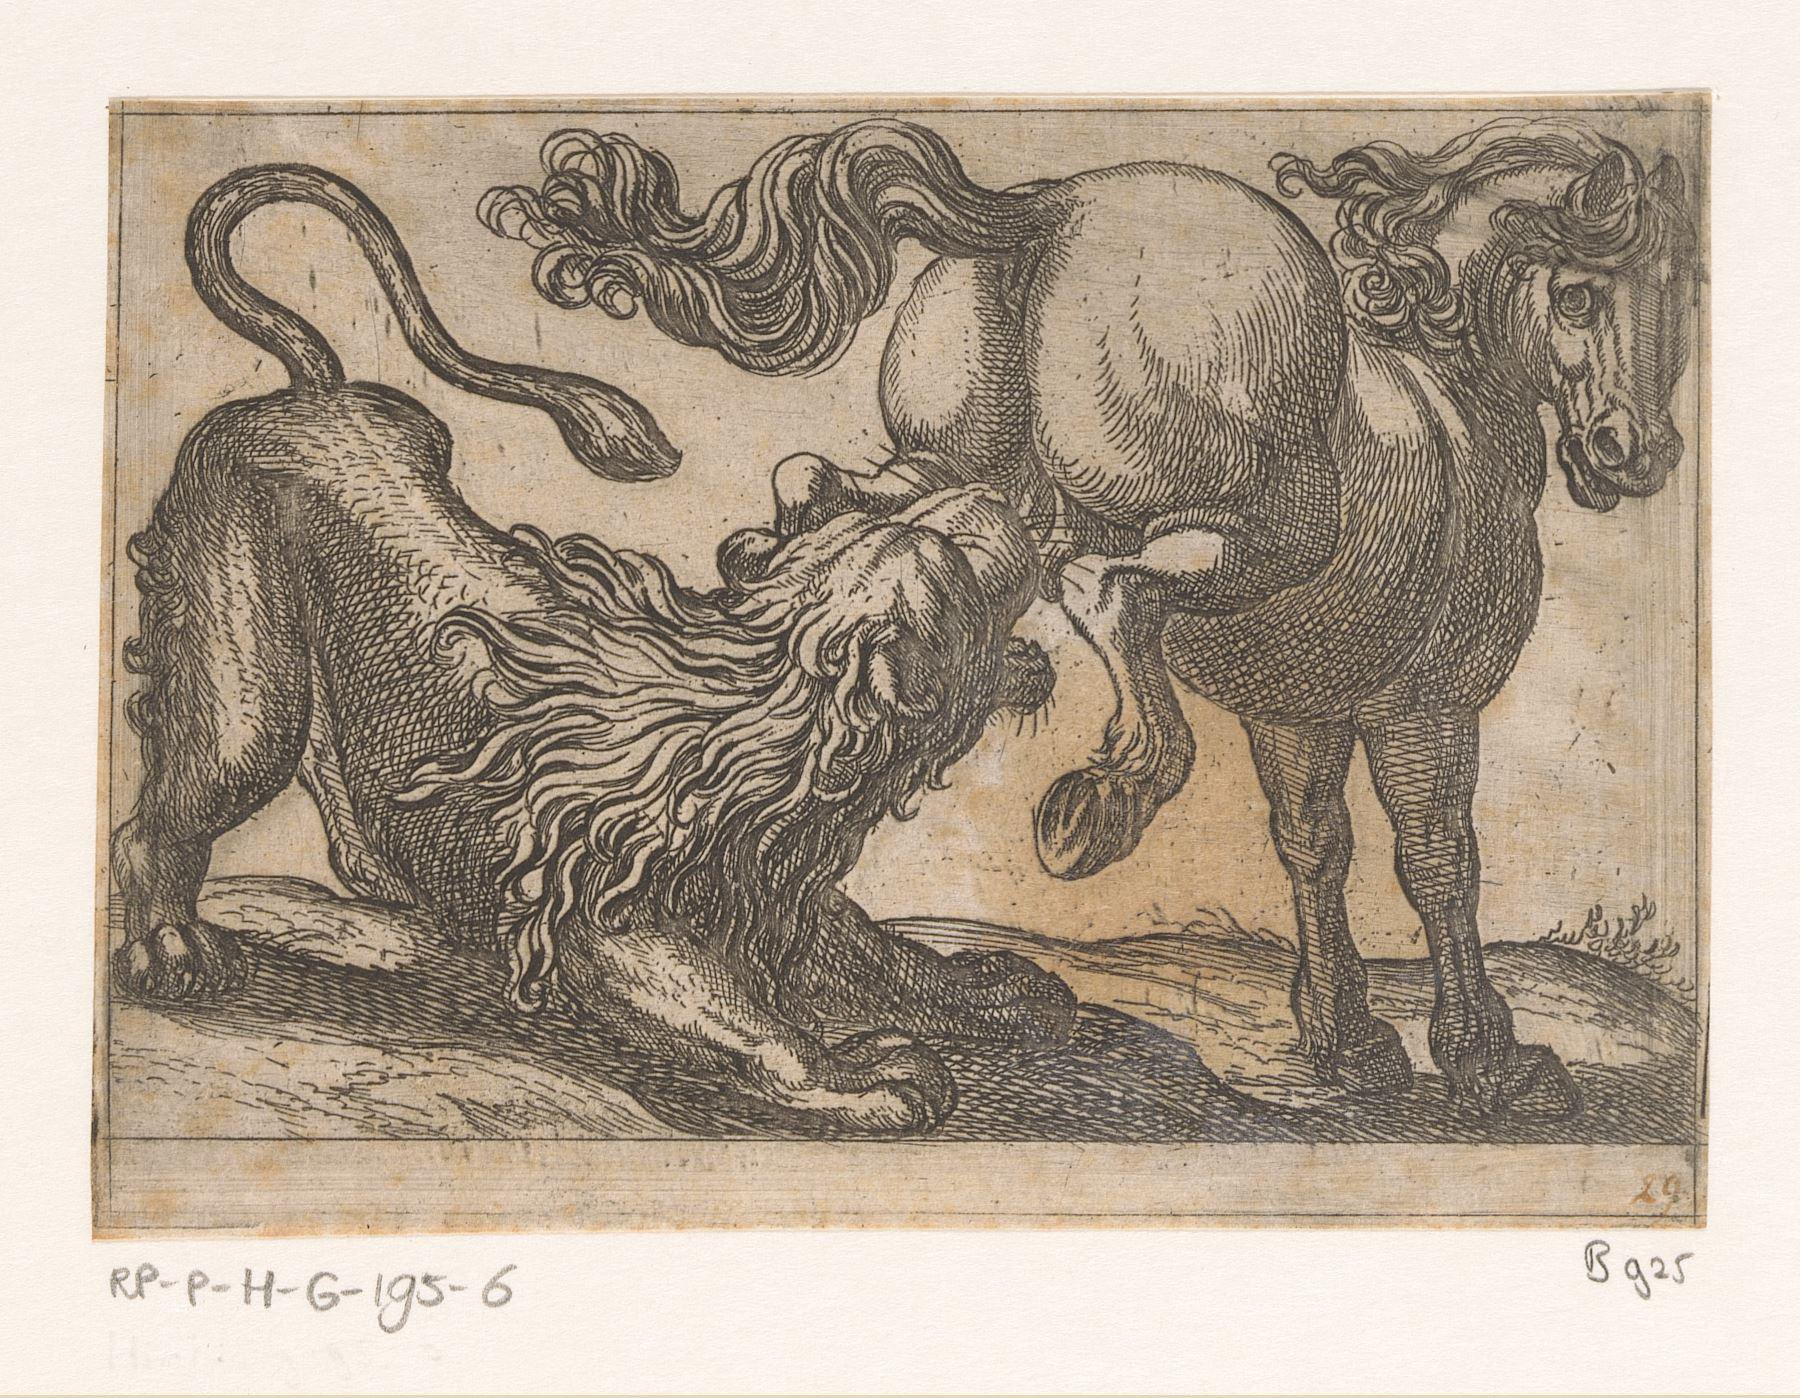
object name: print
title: Een paard een leeuw trappend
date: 1600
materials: paper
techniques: etching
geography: italy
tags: horse, beasts of prey, predatory animals: lion, fighting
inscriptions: collector's mark: ‘Hinloopen’, number: ‘29’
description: Deze prent maakt deel uit van een reeks van 25 prenten (+ titelprent) van vechtende dieren.